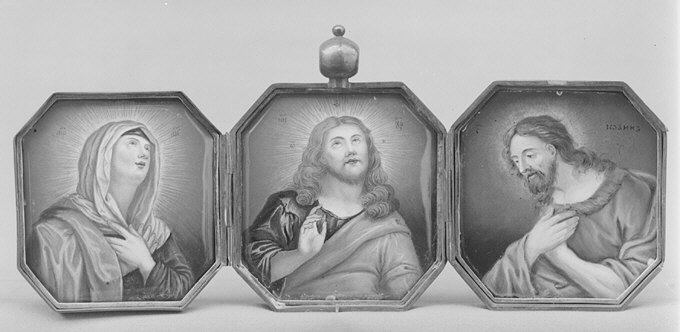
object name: triptych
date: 1801-1900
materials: copper, enamel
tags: christ,saint john the baptist,virgin mary